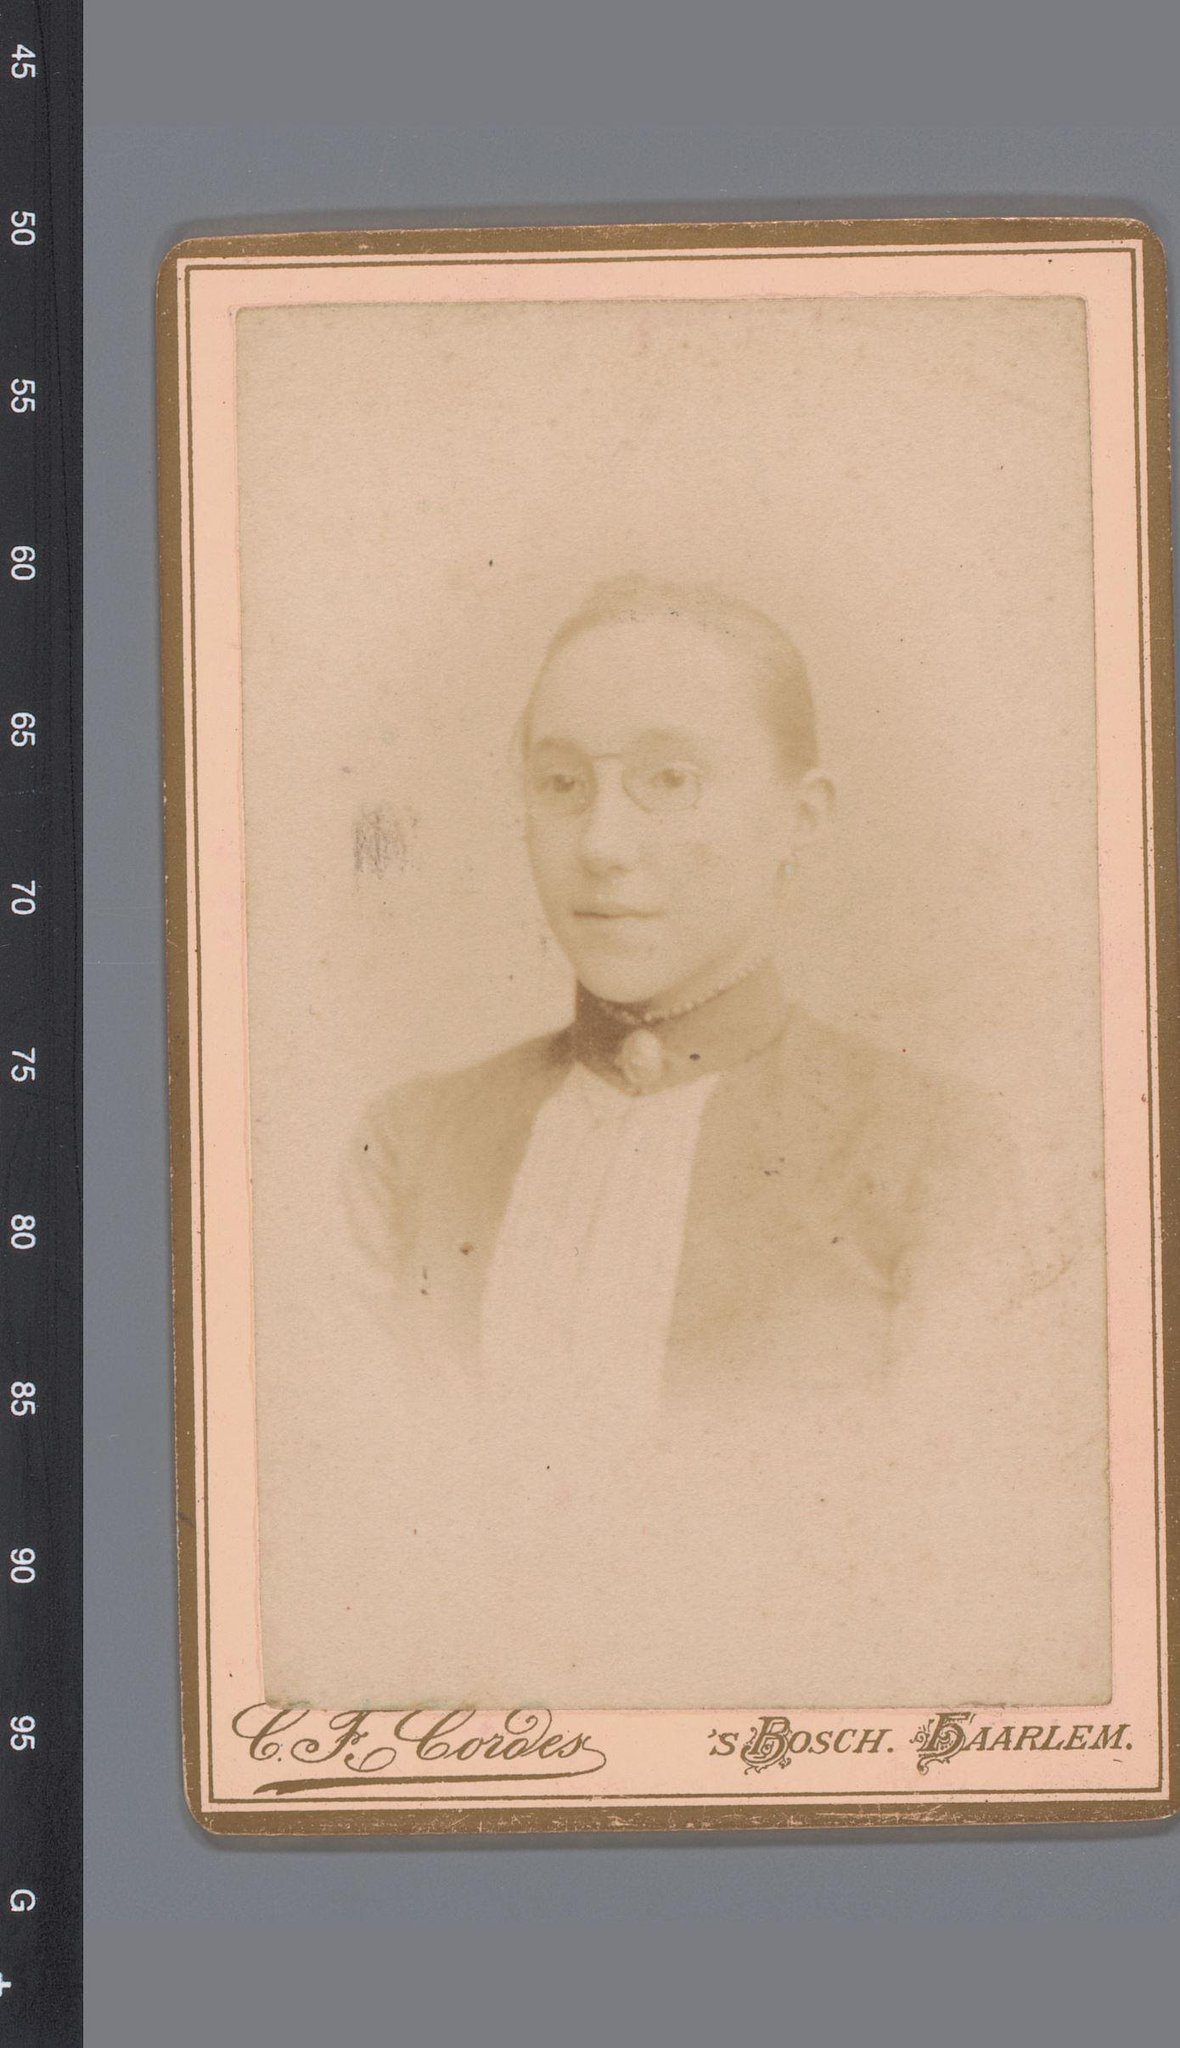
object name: photograph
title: Portret van een onbekende vrouw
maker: carel frederik cordes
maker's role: fotograaf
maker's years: 1851-1927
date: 1881-1901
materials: cardboard, paper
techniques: albumen print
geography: den bosch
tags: adult woman, anonymous historical person portrayed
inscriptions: address: ‘'s Bosch/ aan de Parade/ Haarlem/ Groote Houtstraat.’, inscription: ‘Bijzondere inrichting voor vergrootingen/ (...)’